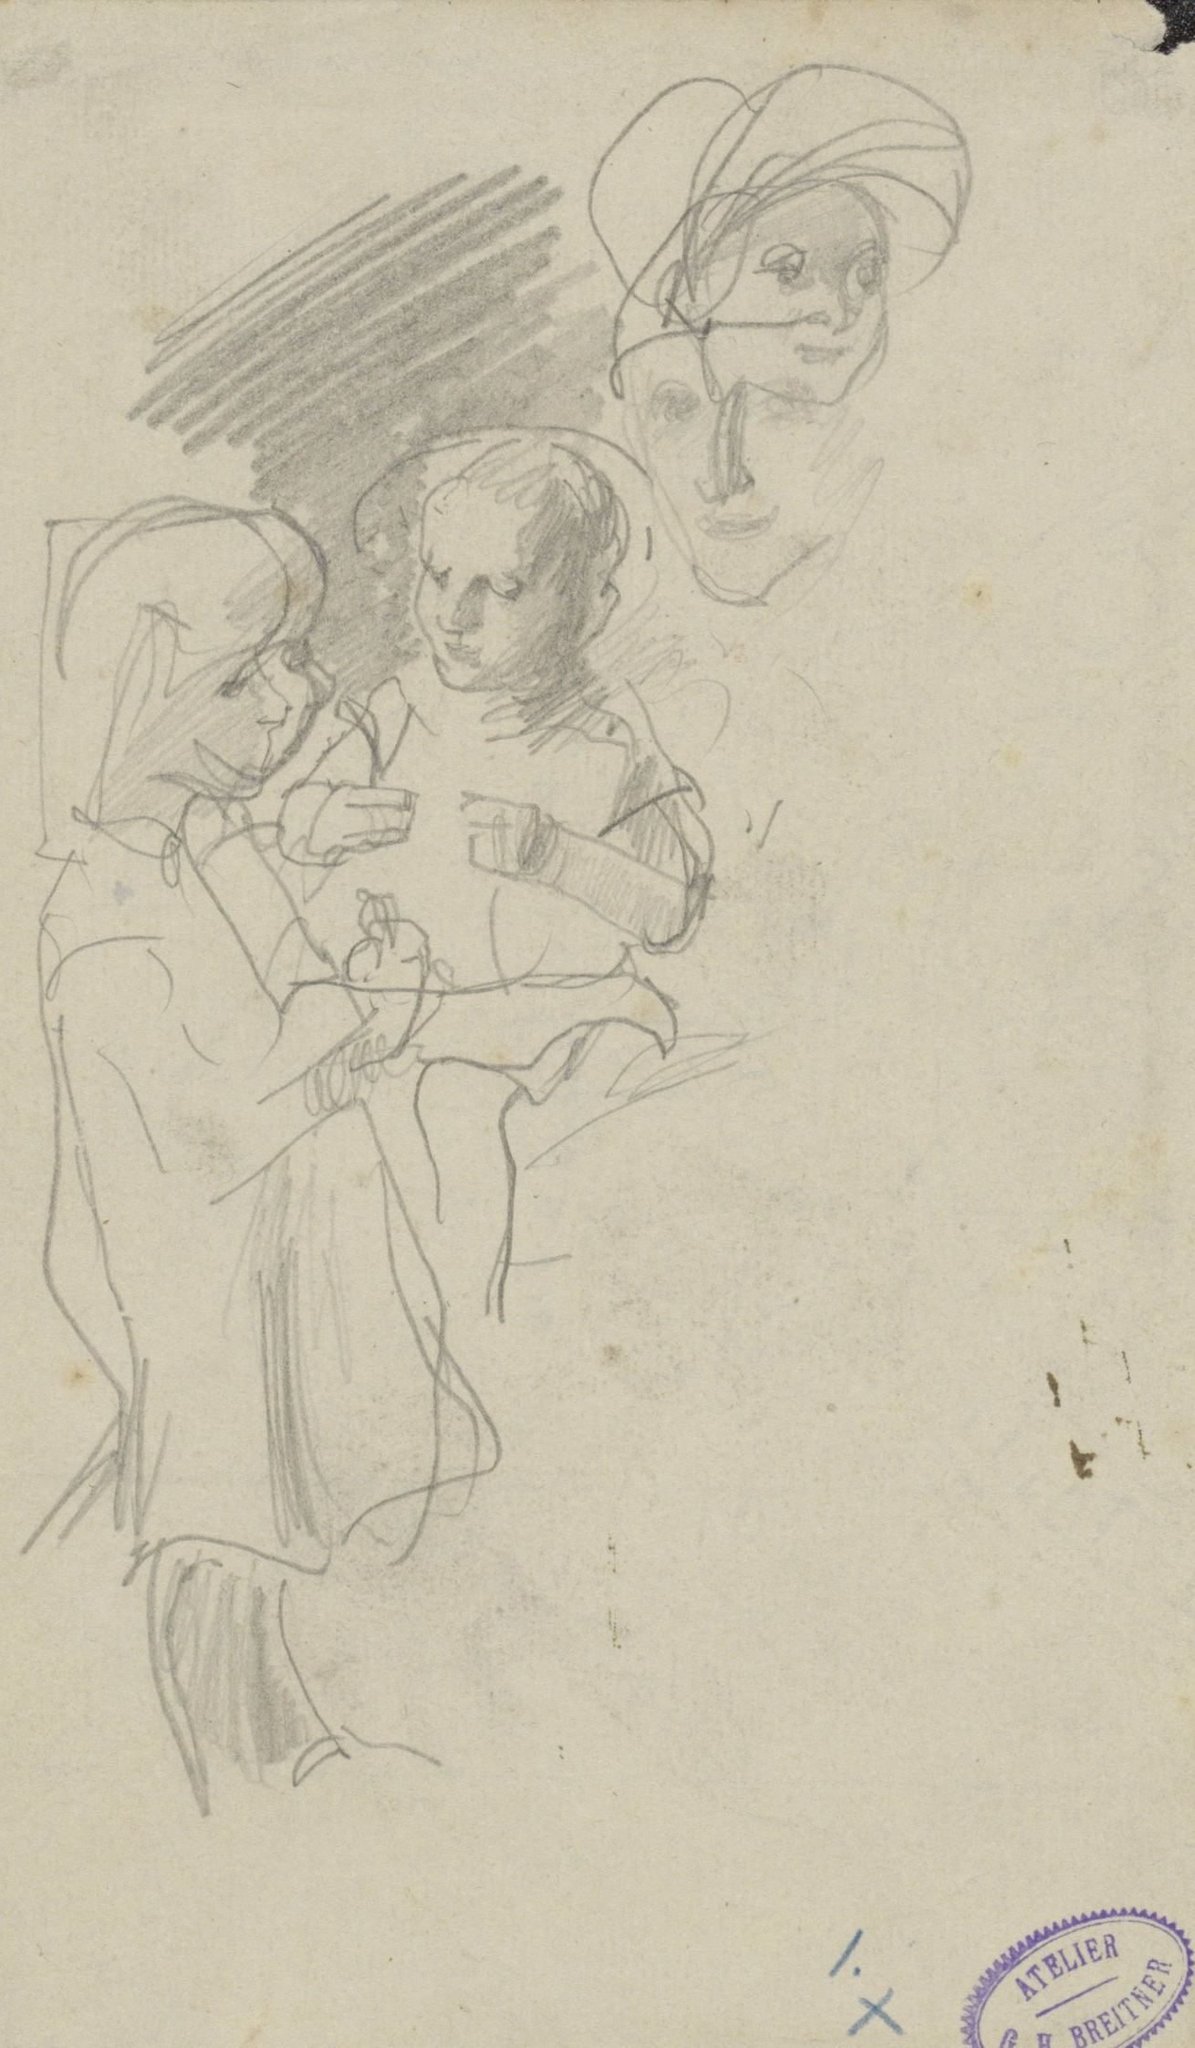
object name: drawing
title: Kinderen en een vrouwenhoofd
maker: george hendrik breitner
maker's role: draughtsman, painter, print maker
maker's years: 1857-1923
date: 1898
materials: paper, pencil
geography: amsterdam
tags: child, head (human) - aa - female human figure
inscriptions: collector's mark: Lugt 2228, workshop stamp: Lugt 291d